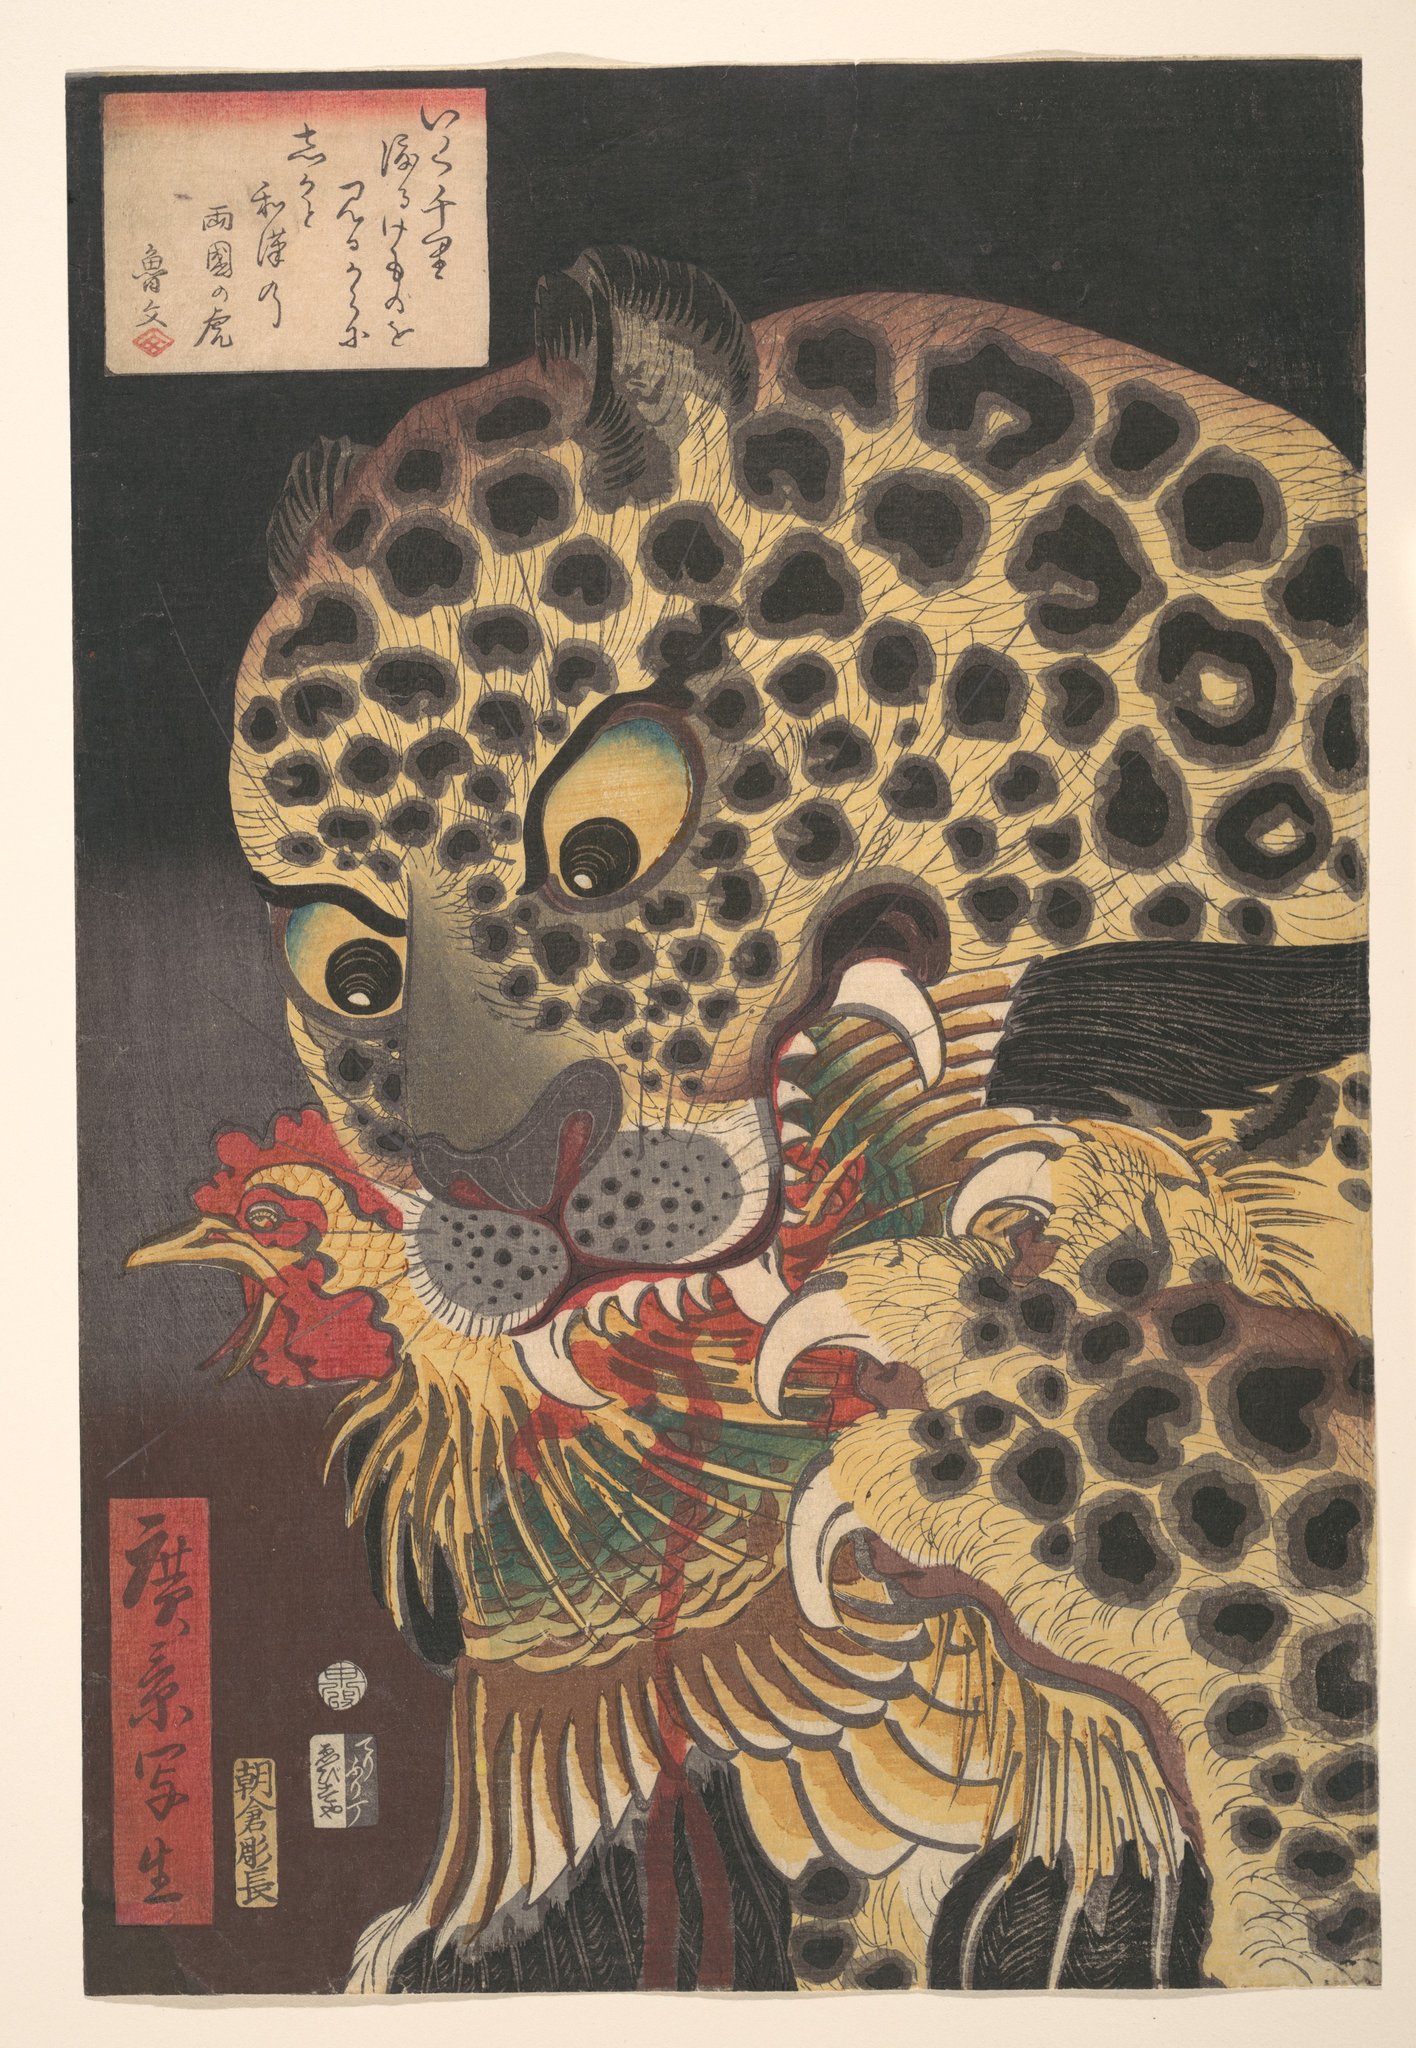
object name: woodblock print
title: “The Tiger of Ryōkoku,” from the series True Scenes by Hirokage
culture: japanese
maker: utagawa hirokage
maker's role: artist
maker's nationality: japanese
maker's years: 1860-1869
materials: ink, paper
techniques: woodblock print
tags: chickens,tigers